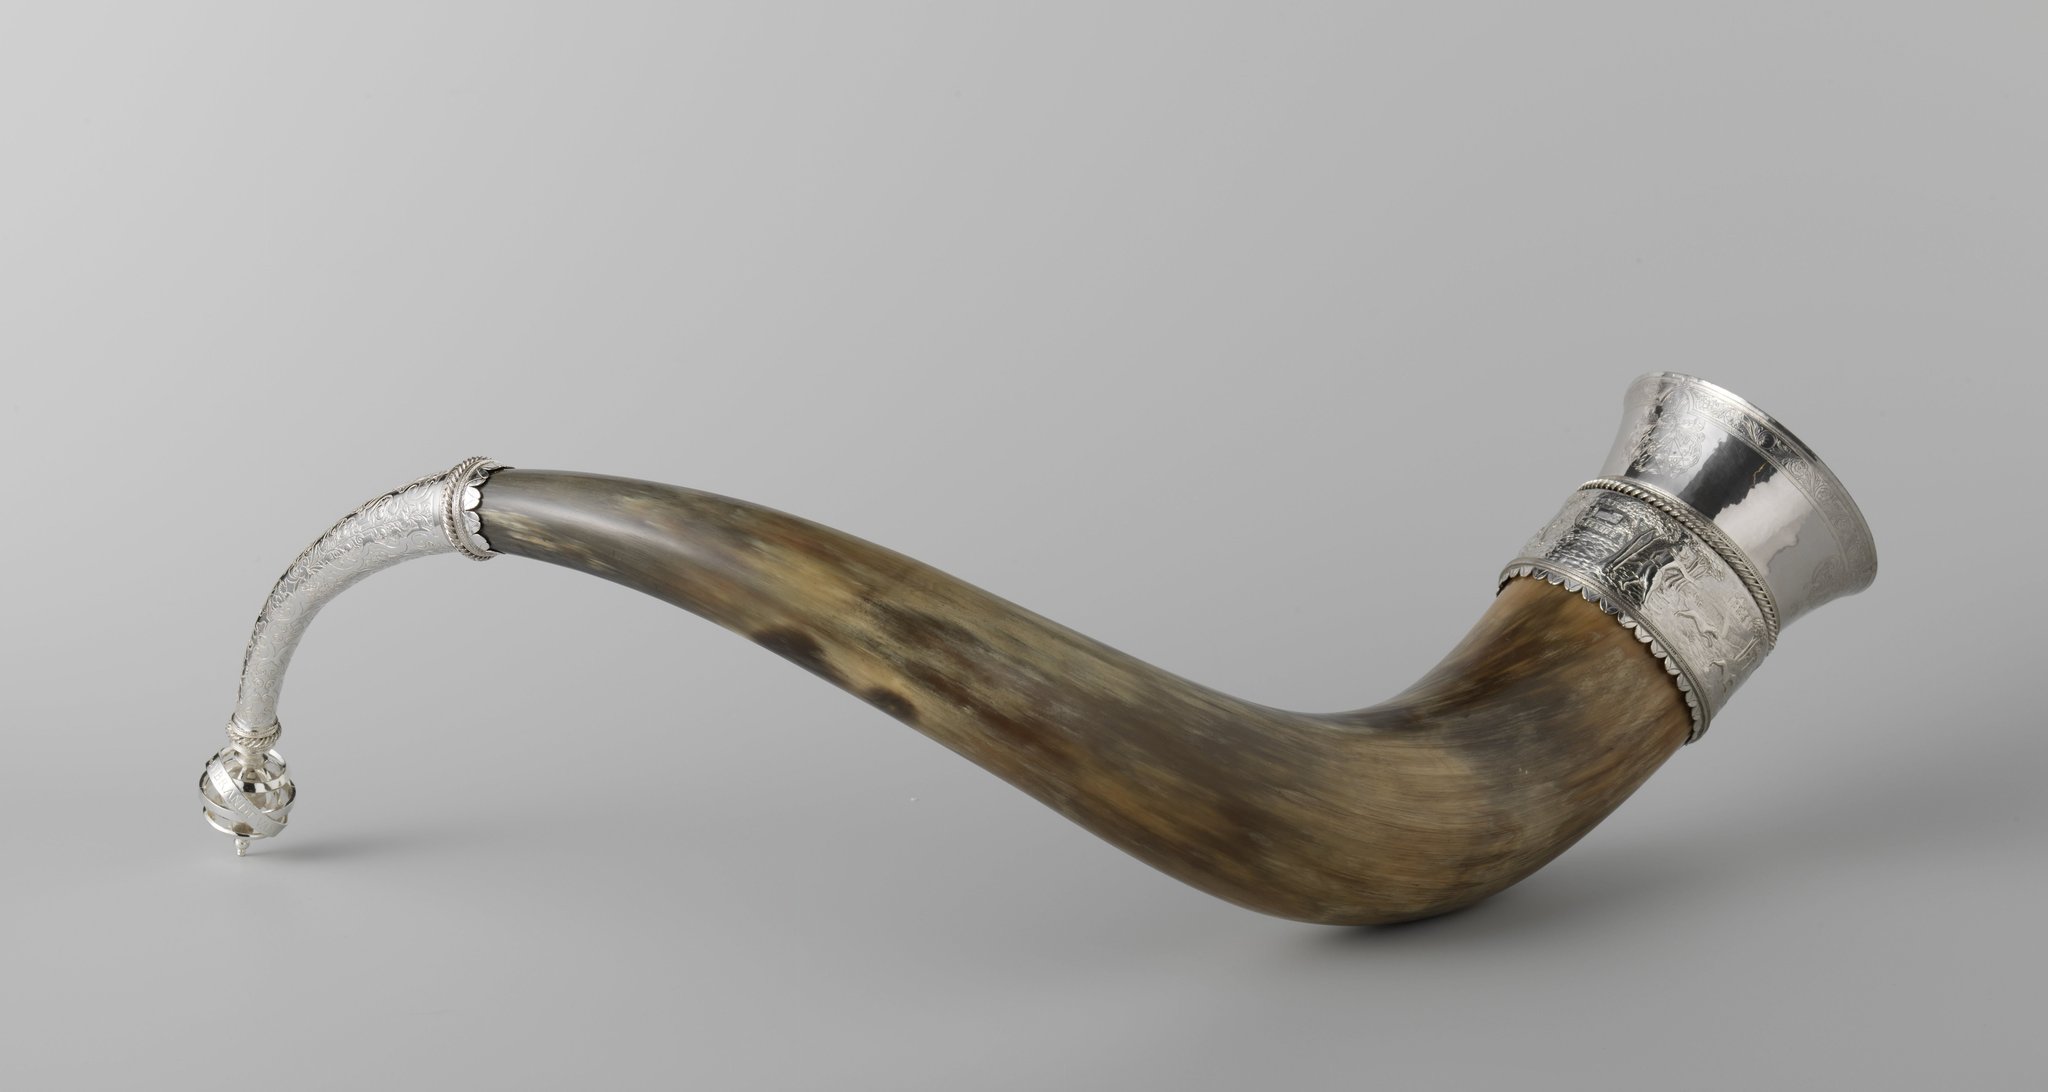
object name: drinking horn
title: Drinkhoorn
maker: jan stoffels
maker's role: silversmith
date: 1609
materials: horn, silver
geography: bolsward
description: Drinkhoorn van runderhoorn met zilveren rand. Langs de liprand onder andere een gegraveerd alliantie-wapen met huwelijksknoop van de geslachten van Osinga en van Aggama.